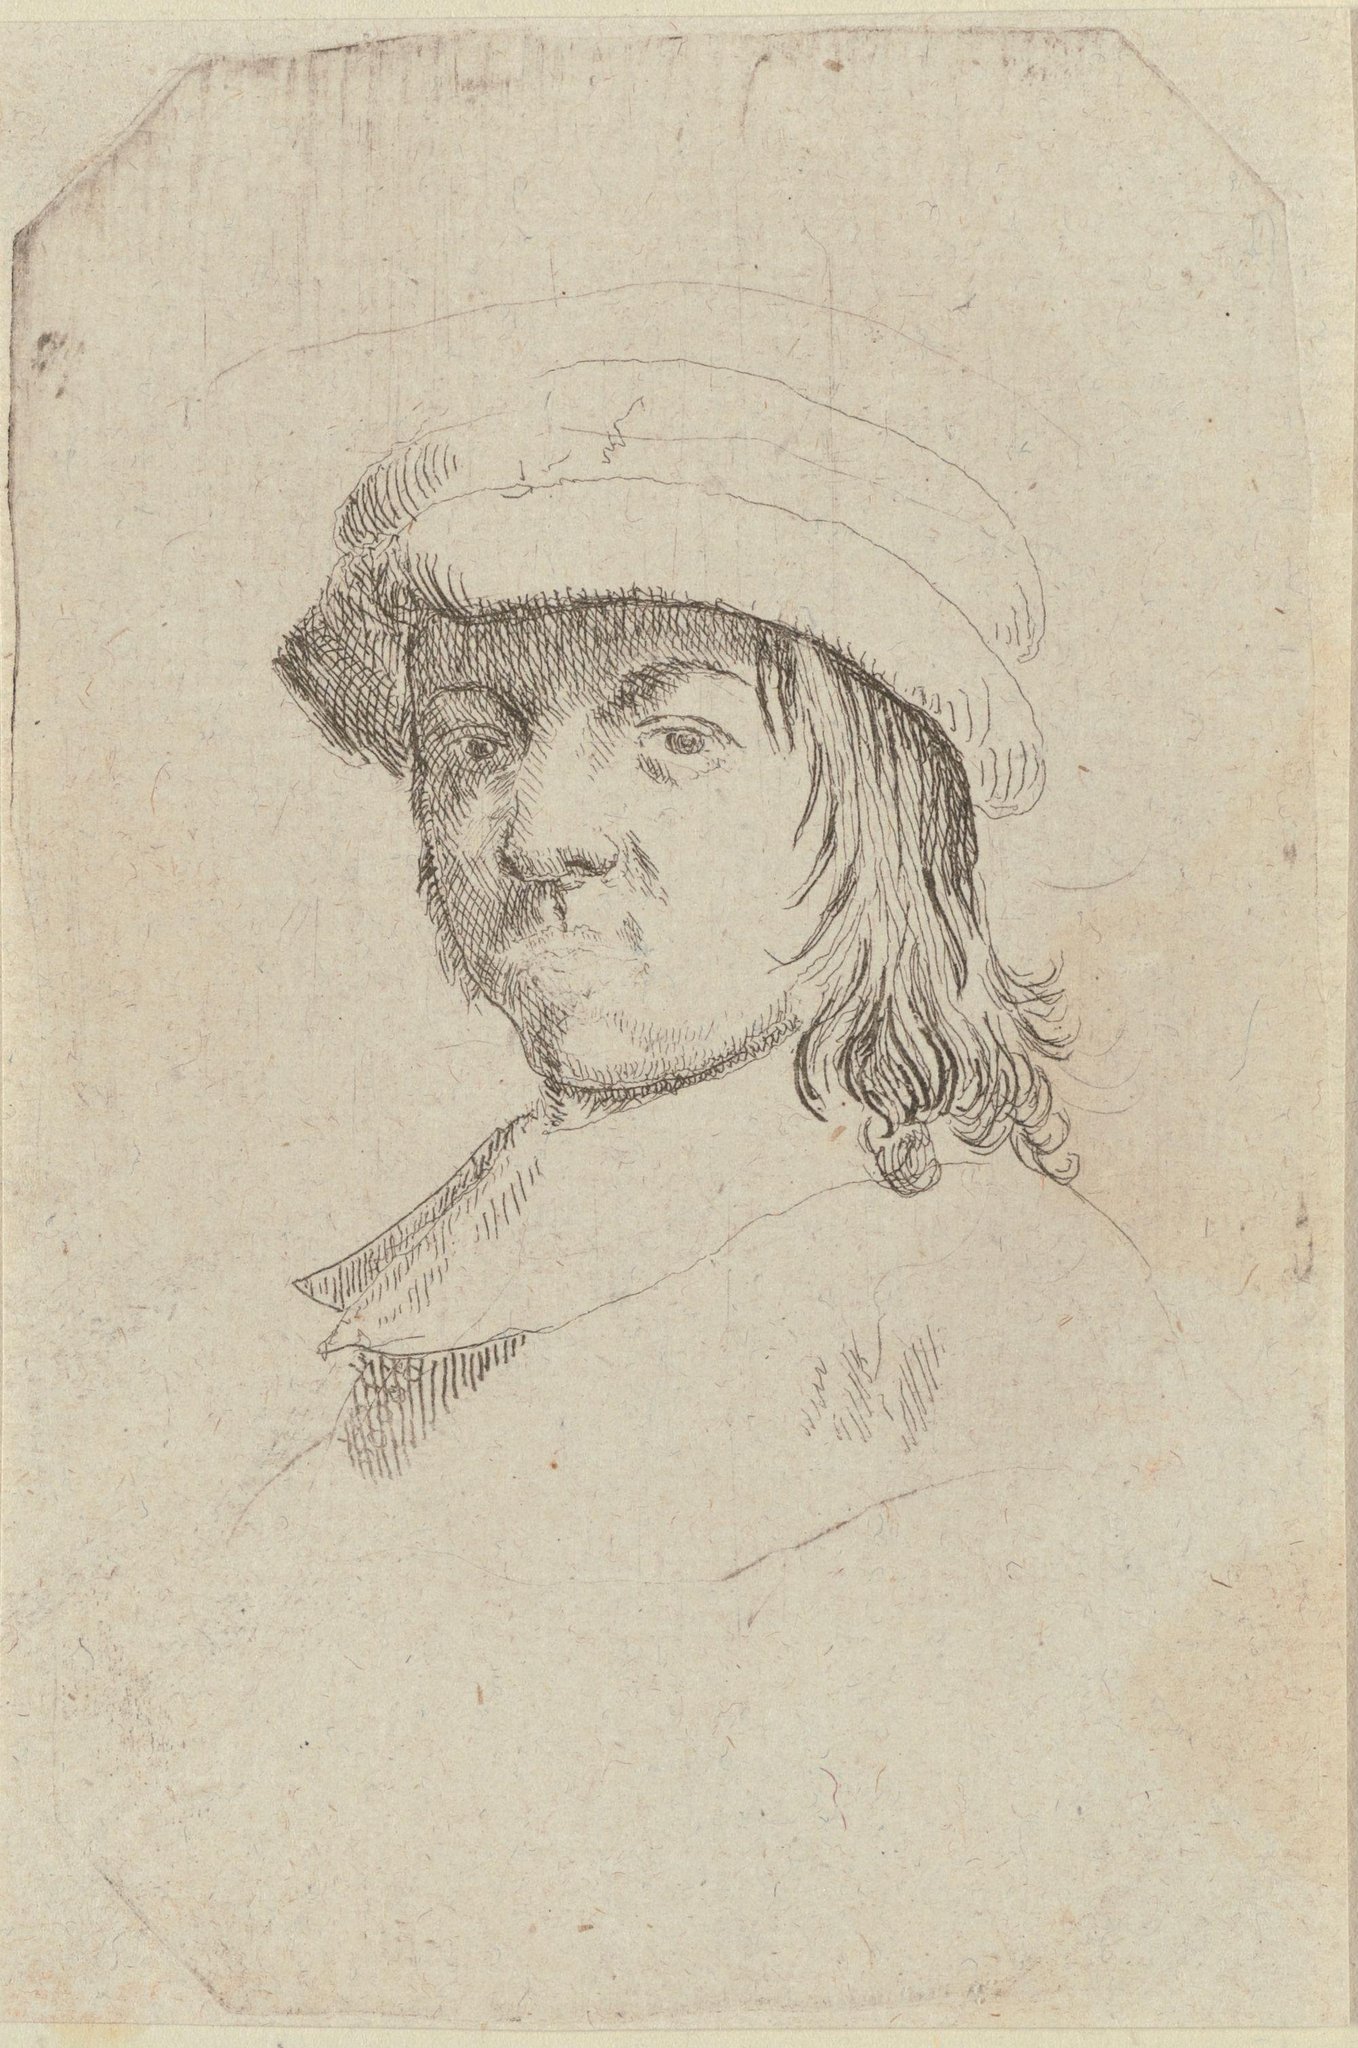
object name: print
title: Buste van een man met muts op het hoofd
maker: Anonymous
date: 1700-1886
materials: paper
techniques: etching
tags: head-gear: cap (+ men's clothes)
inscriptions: collector's mark: Lugt 2228